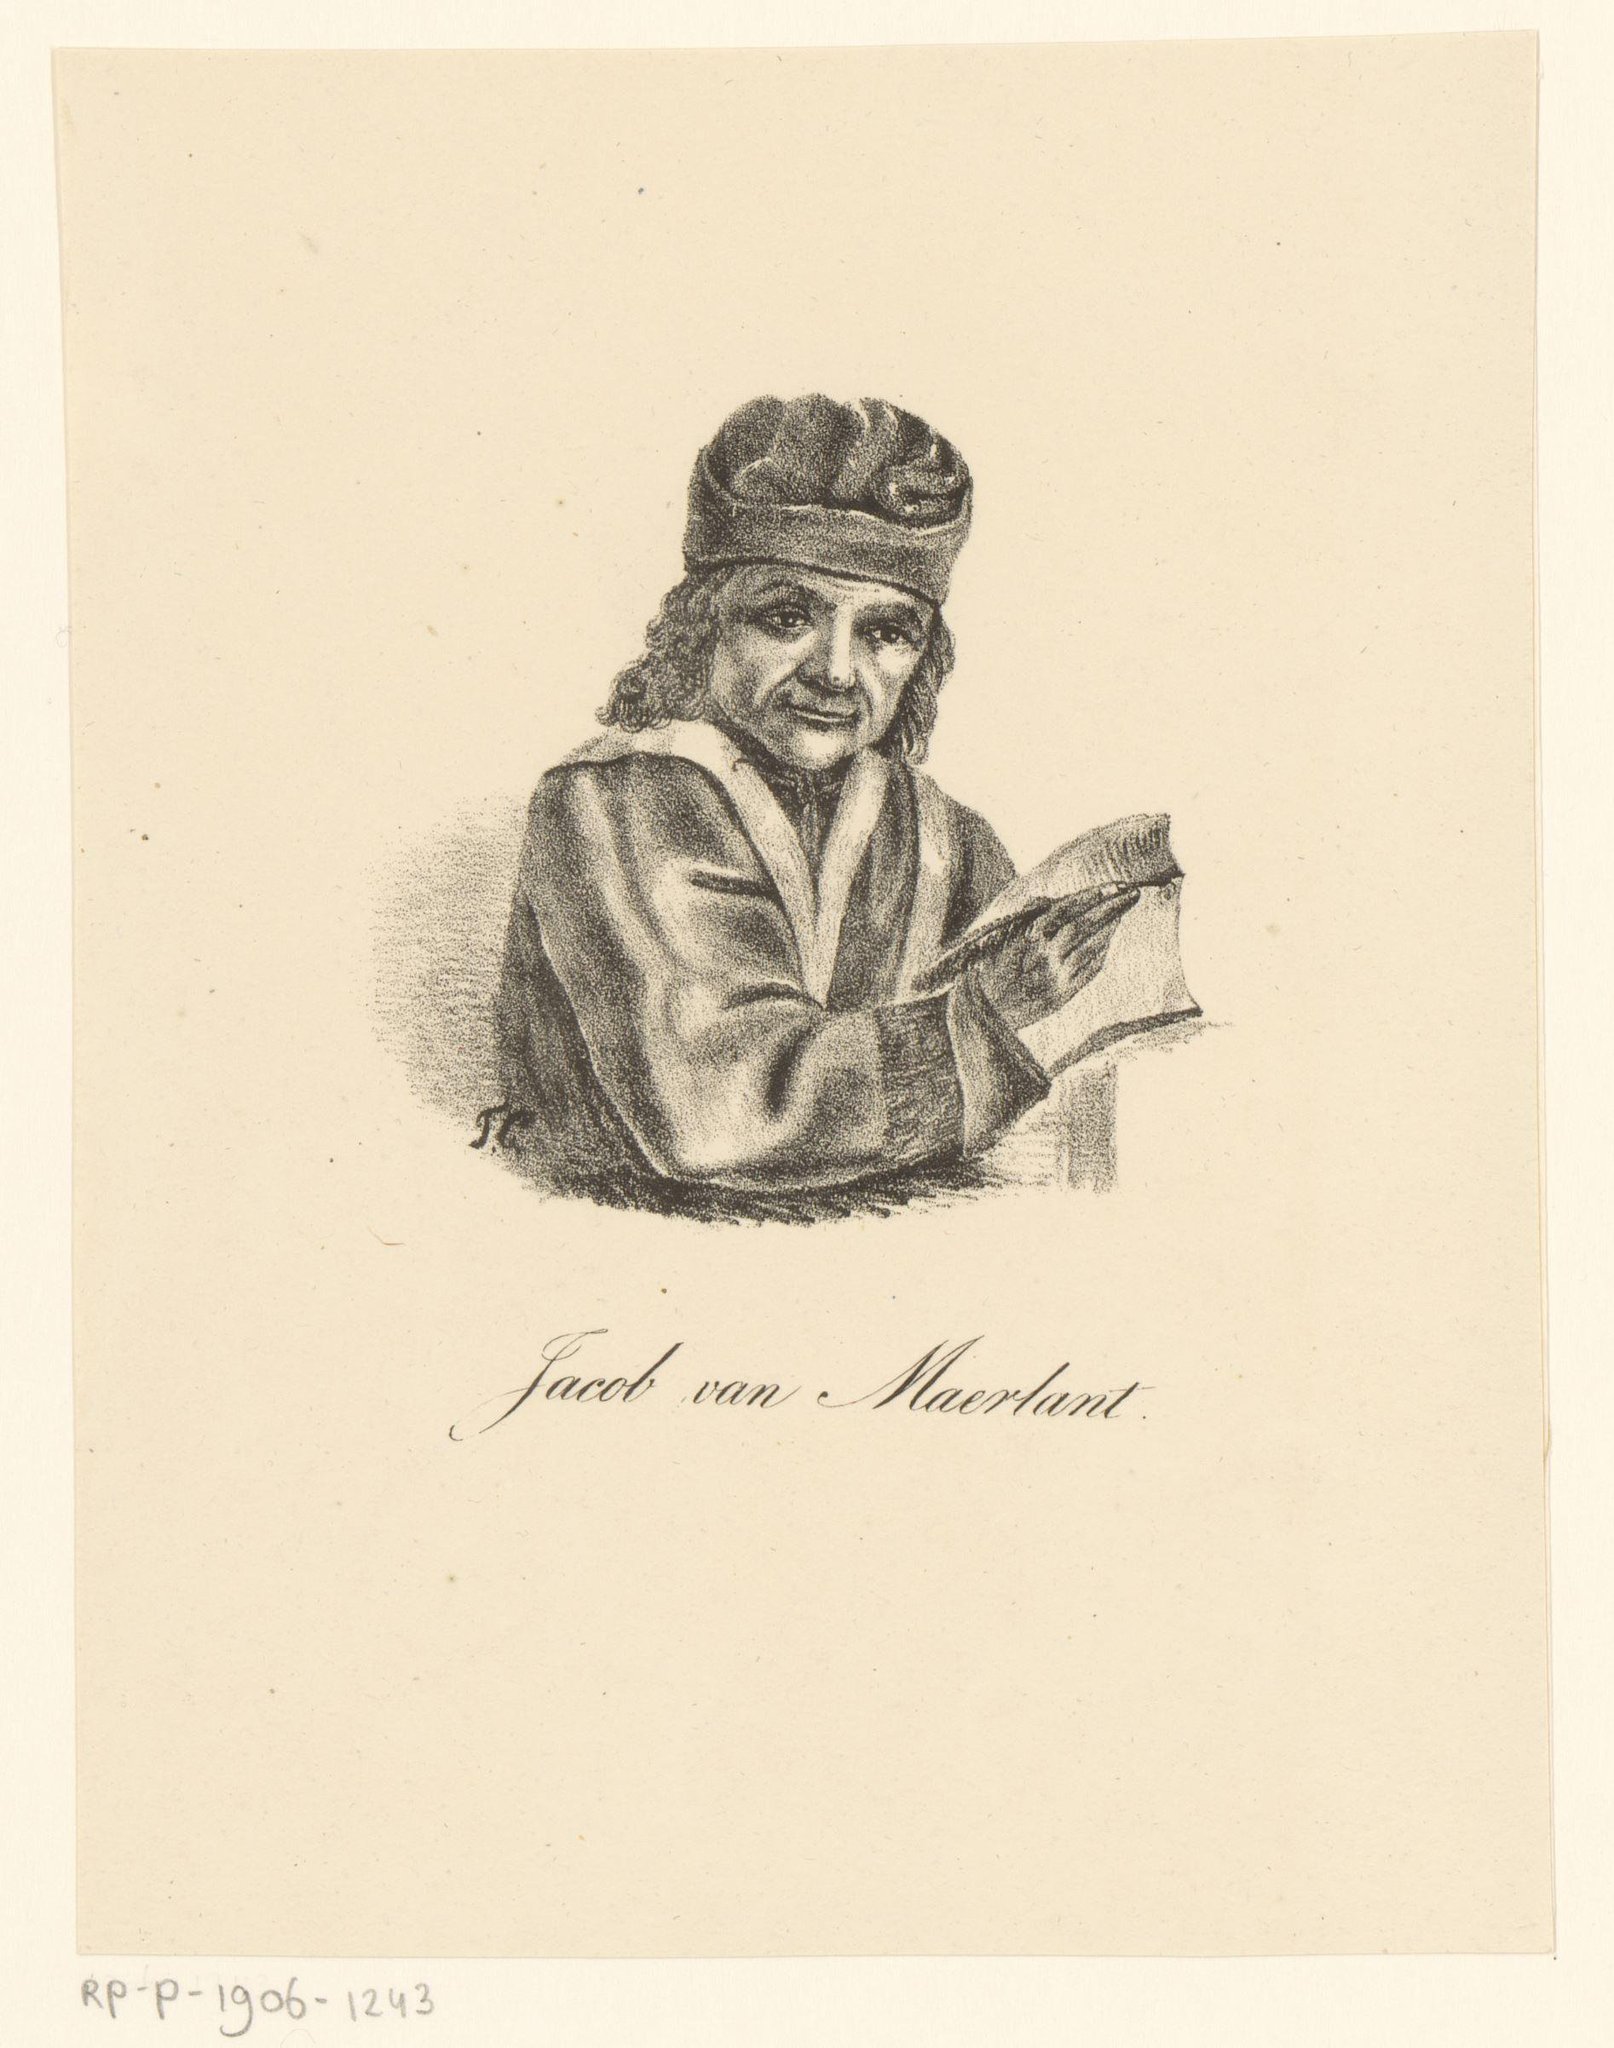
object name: print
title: Portret van Jacob van Maerlant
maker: Anonymous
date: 1809-1853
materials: paper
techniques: lithograph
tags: notebook, writing accessories, historical persons (+ (full) bust portrait)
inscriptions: monogram: ‘T.C.’, collector's mark: Lugt 2228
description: De geportretteerde schrijft in een schrift.